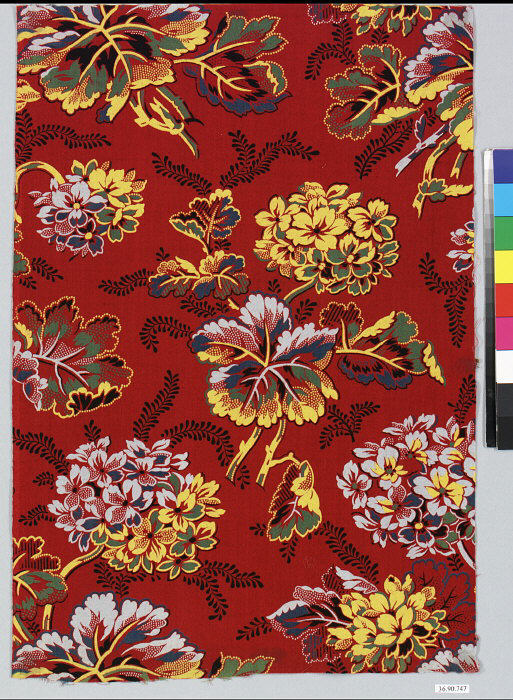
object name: piece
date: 1867-1900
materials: cotton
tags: flowers,leaves